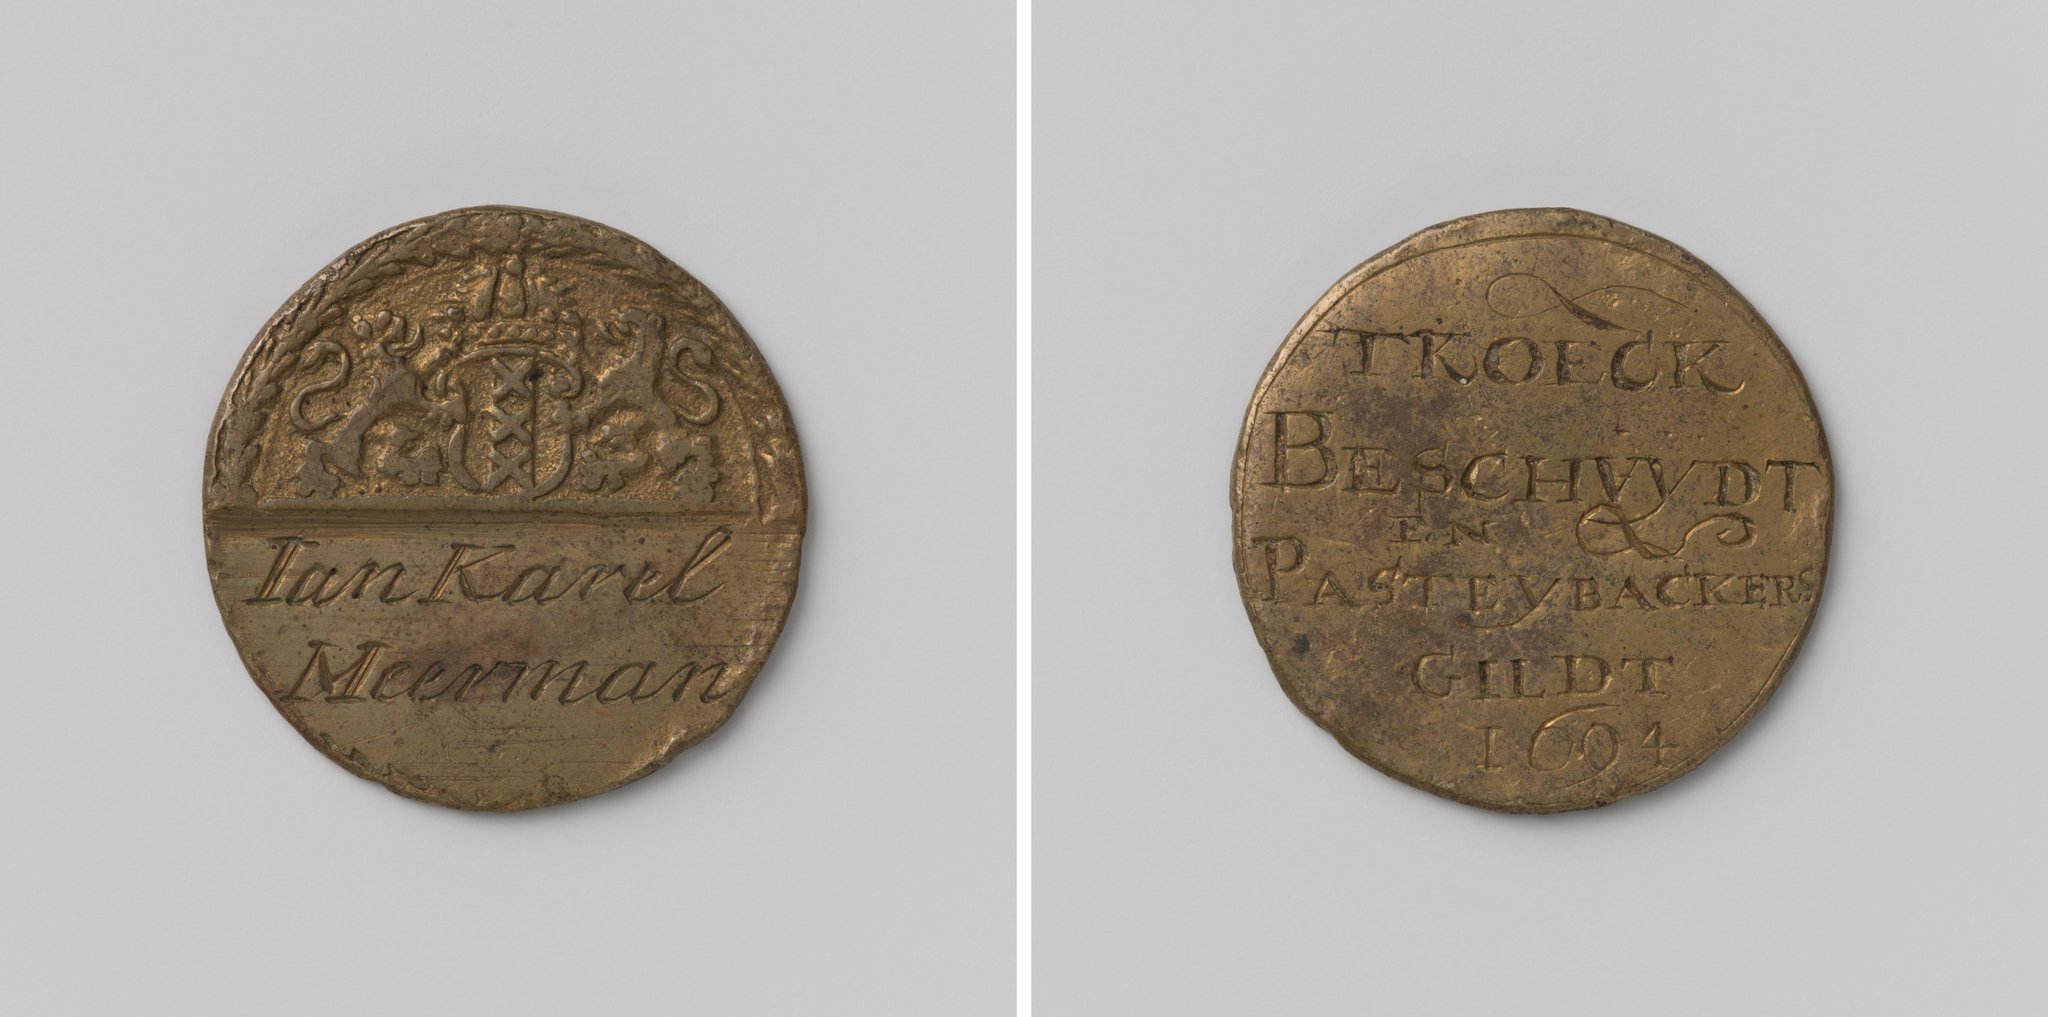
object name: medal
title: Koek-, beschuit- en pasteibakkersgilde van Amsterdam, gildepenning van Jan Karel Meerman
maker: Anonymous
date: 1694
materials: brass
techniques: casting, engraving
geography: amsterdam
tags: amsterdam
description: Messing penning. Voorzijde: gekroond wapenschild, geflankeerd door twee leeuwen binnen bladerkrans; afsnede: opschrift. Keerzijde: opschrift.